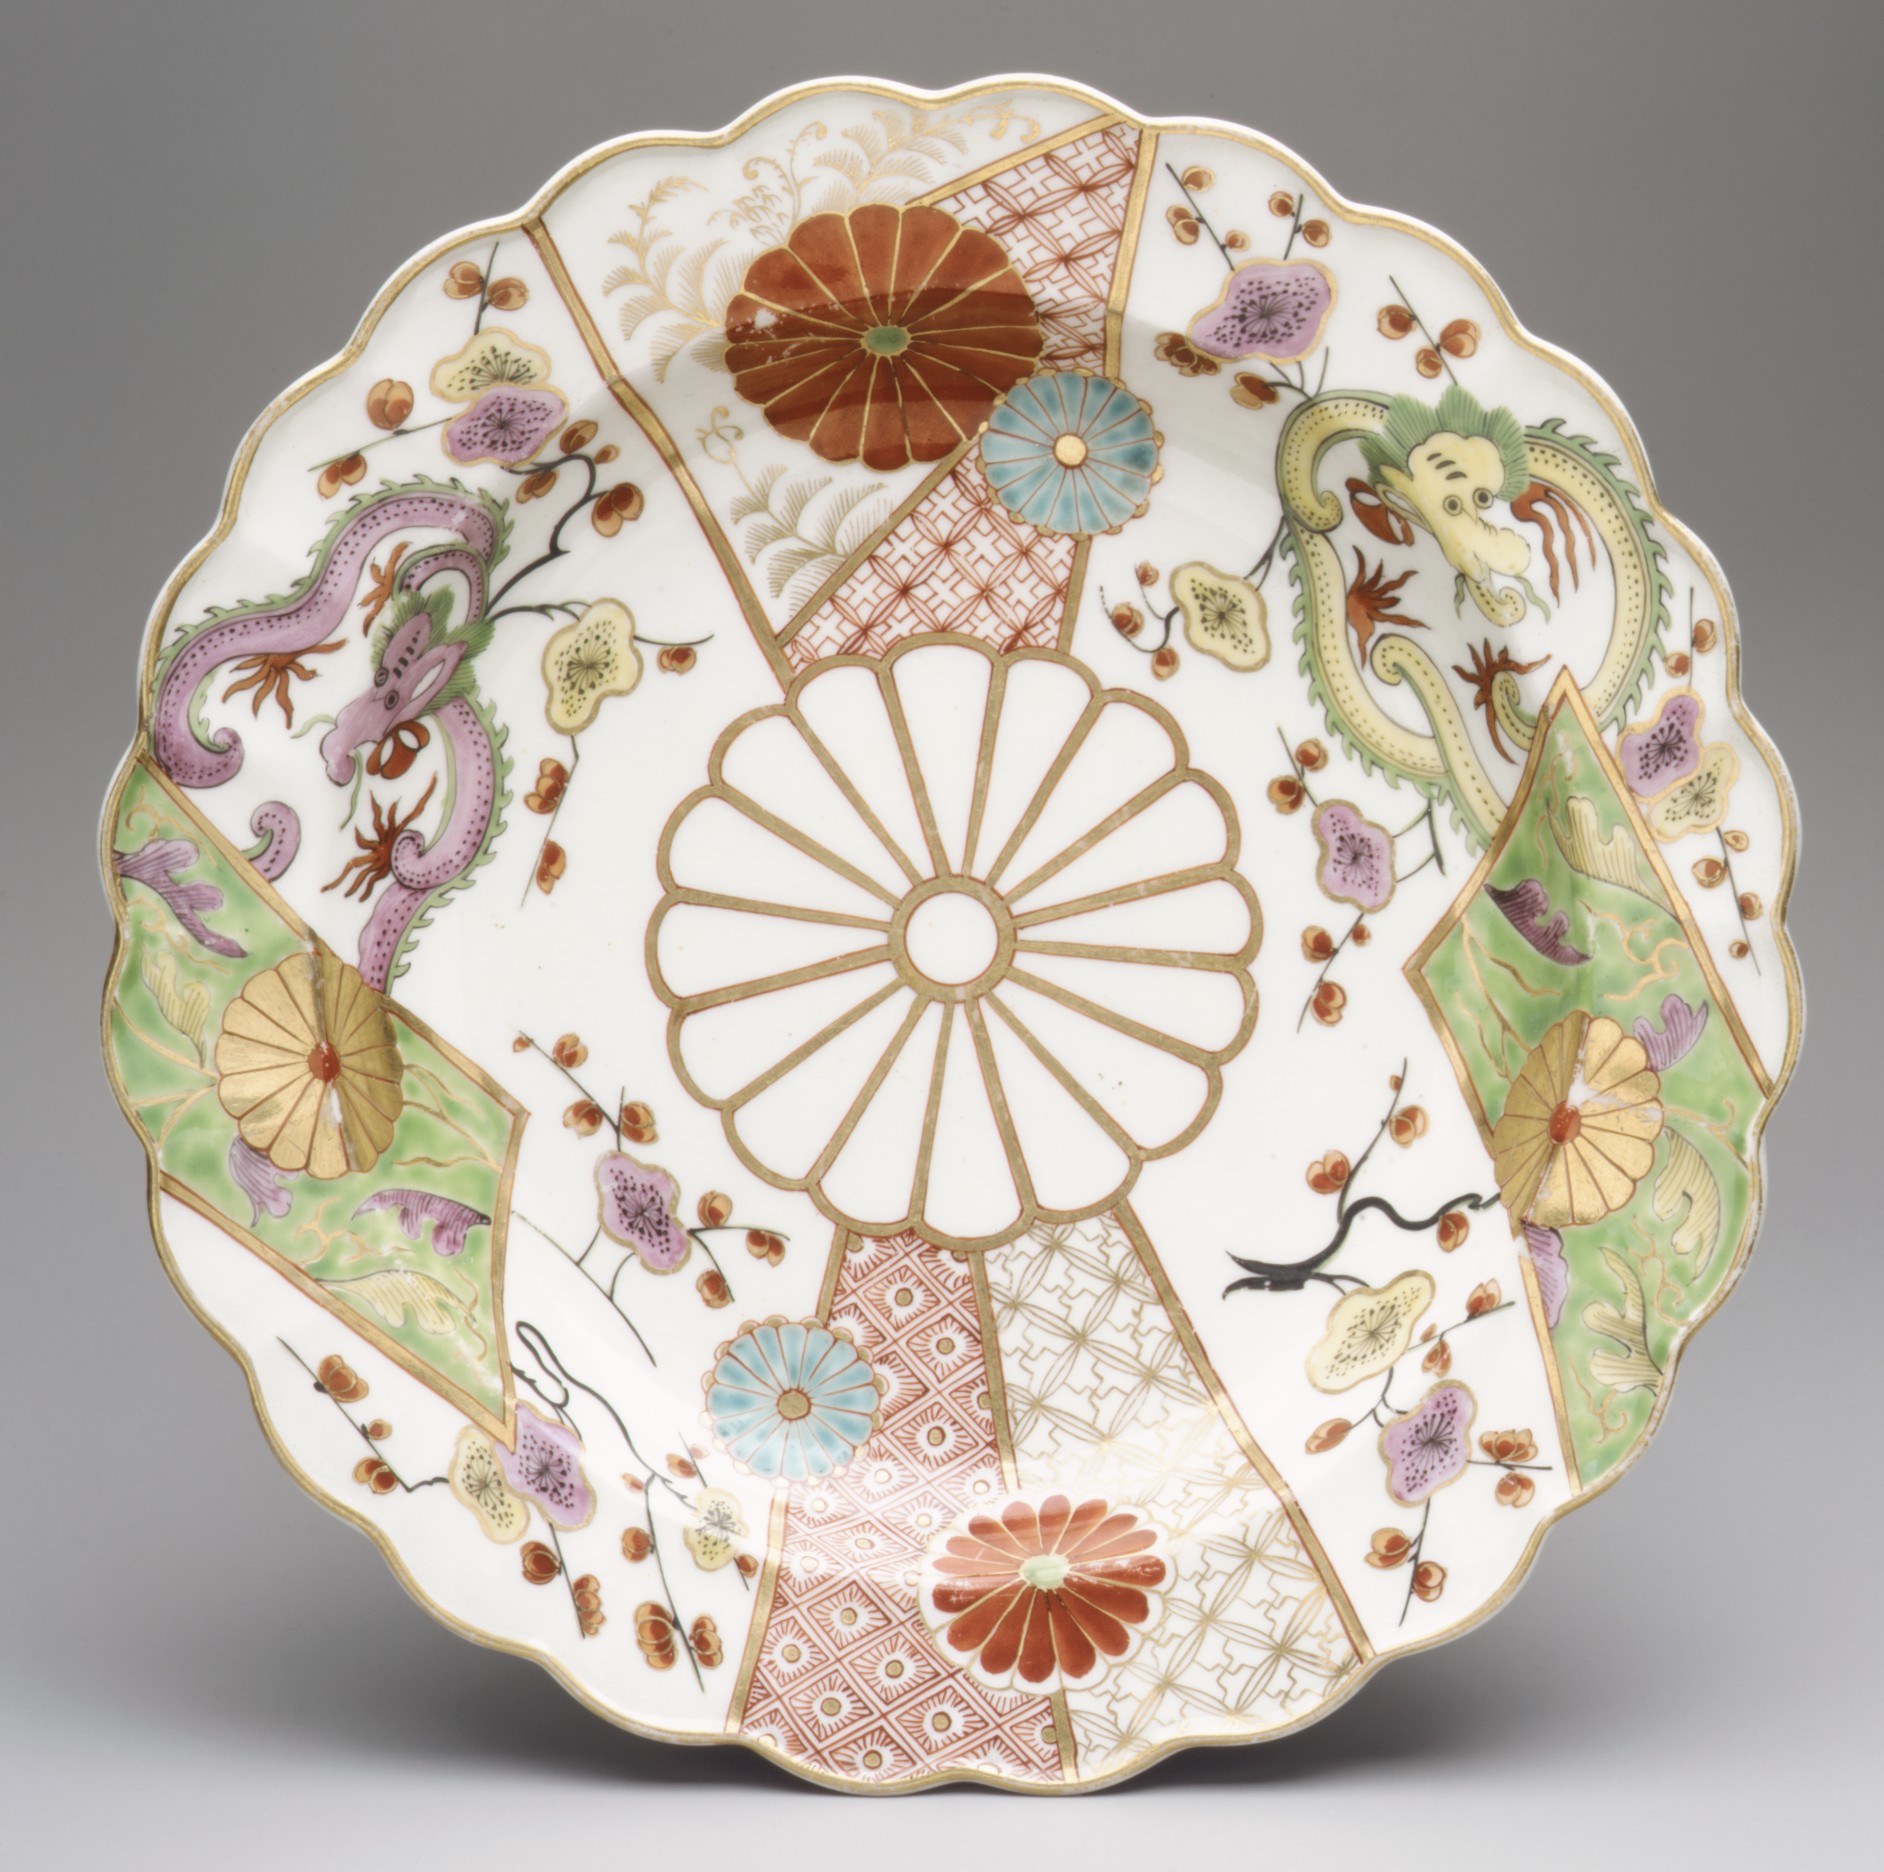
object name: plate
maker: worcester factory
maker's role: factory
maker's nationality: british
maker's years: 1751-2008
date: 1772-1775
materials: soft paste porcelain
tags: dragons,flowers